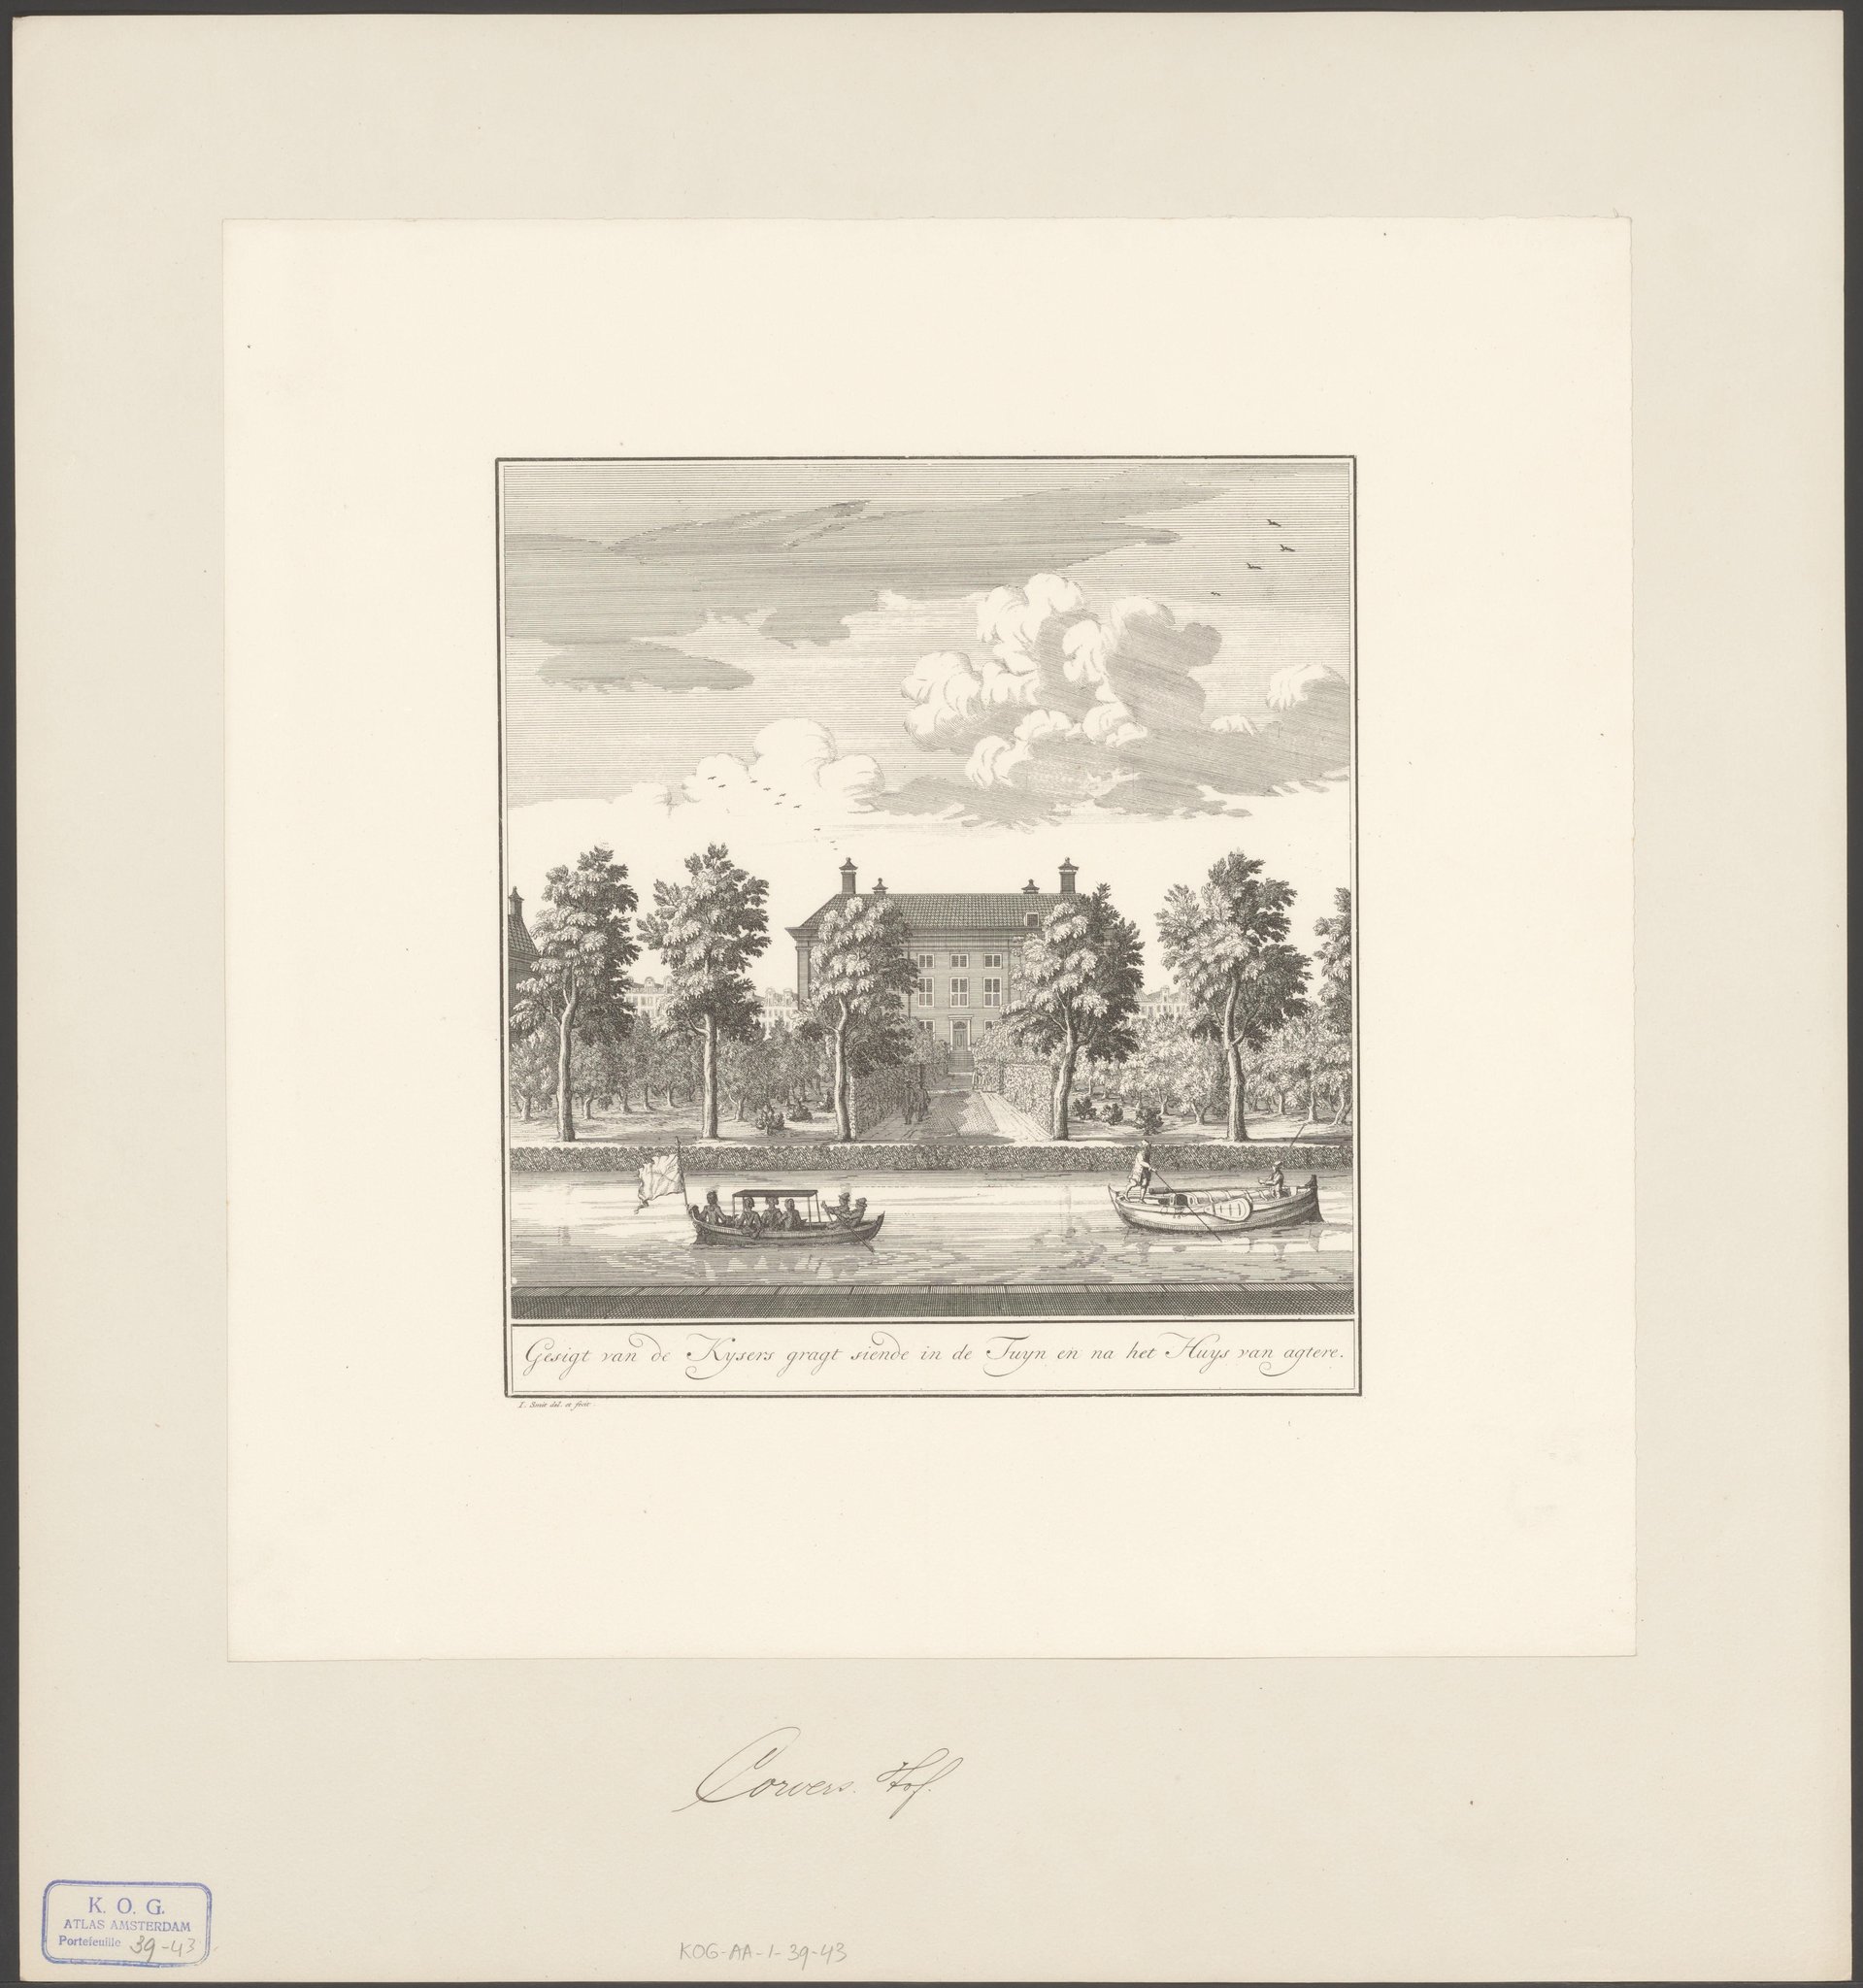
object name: photomechanical print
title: Gezicht op de tuin en de achtergevel van het Corvershof te Amsterdam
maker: Anonymous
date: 1855-1940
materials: paper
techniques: photolithography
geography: northern netherlands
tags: alms-house (dutch: 'hofje'), garden, rowing-boat, canoe, etc., canals, waters (in city) (+ city(-scape) with figures, staffage)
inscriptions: collector's mark: Lugt 1641b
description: Onderwerpsrubriek binnen de Atlas Amsterdam: Armwezen en liefdadige instellingen: III. Verschillende gestichten en instellingen / Hofjes: Corvershof der N. Hervormde Gemeente.